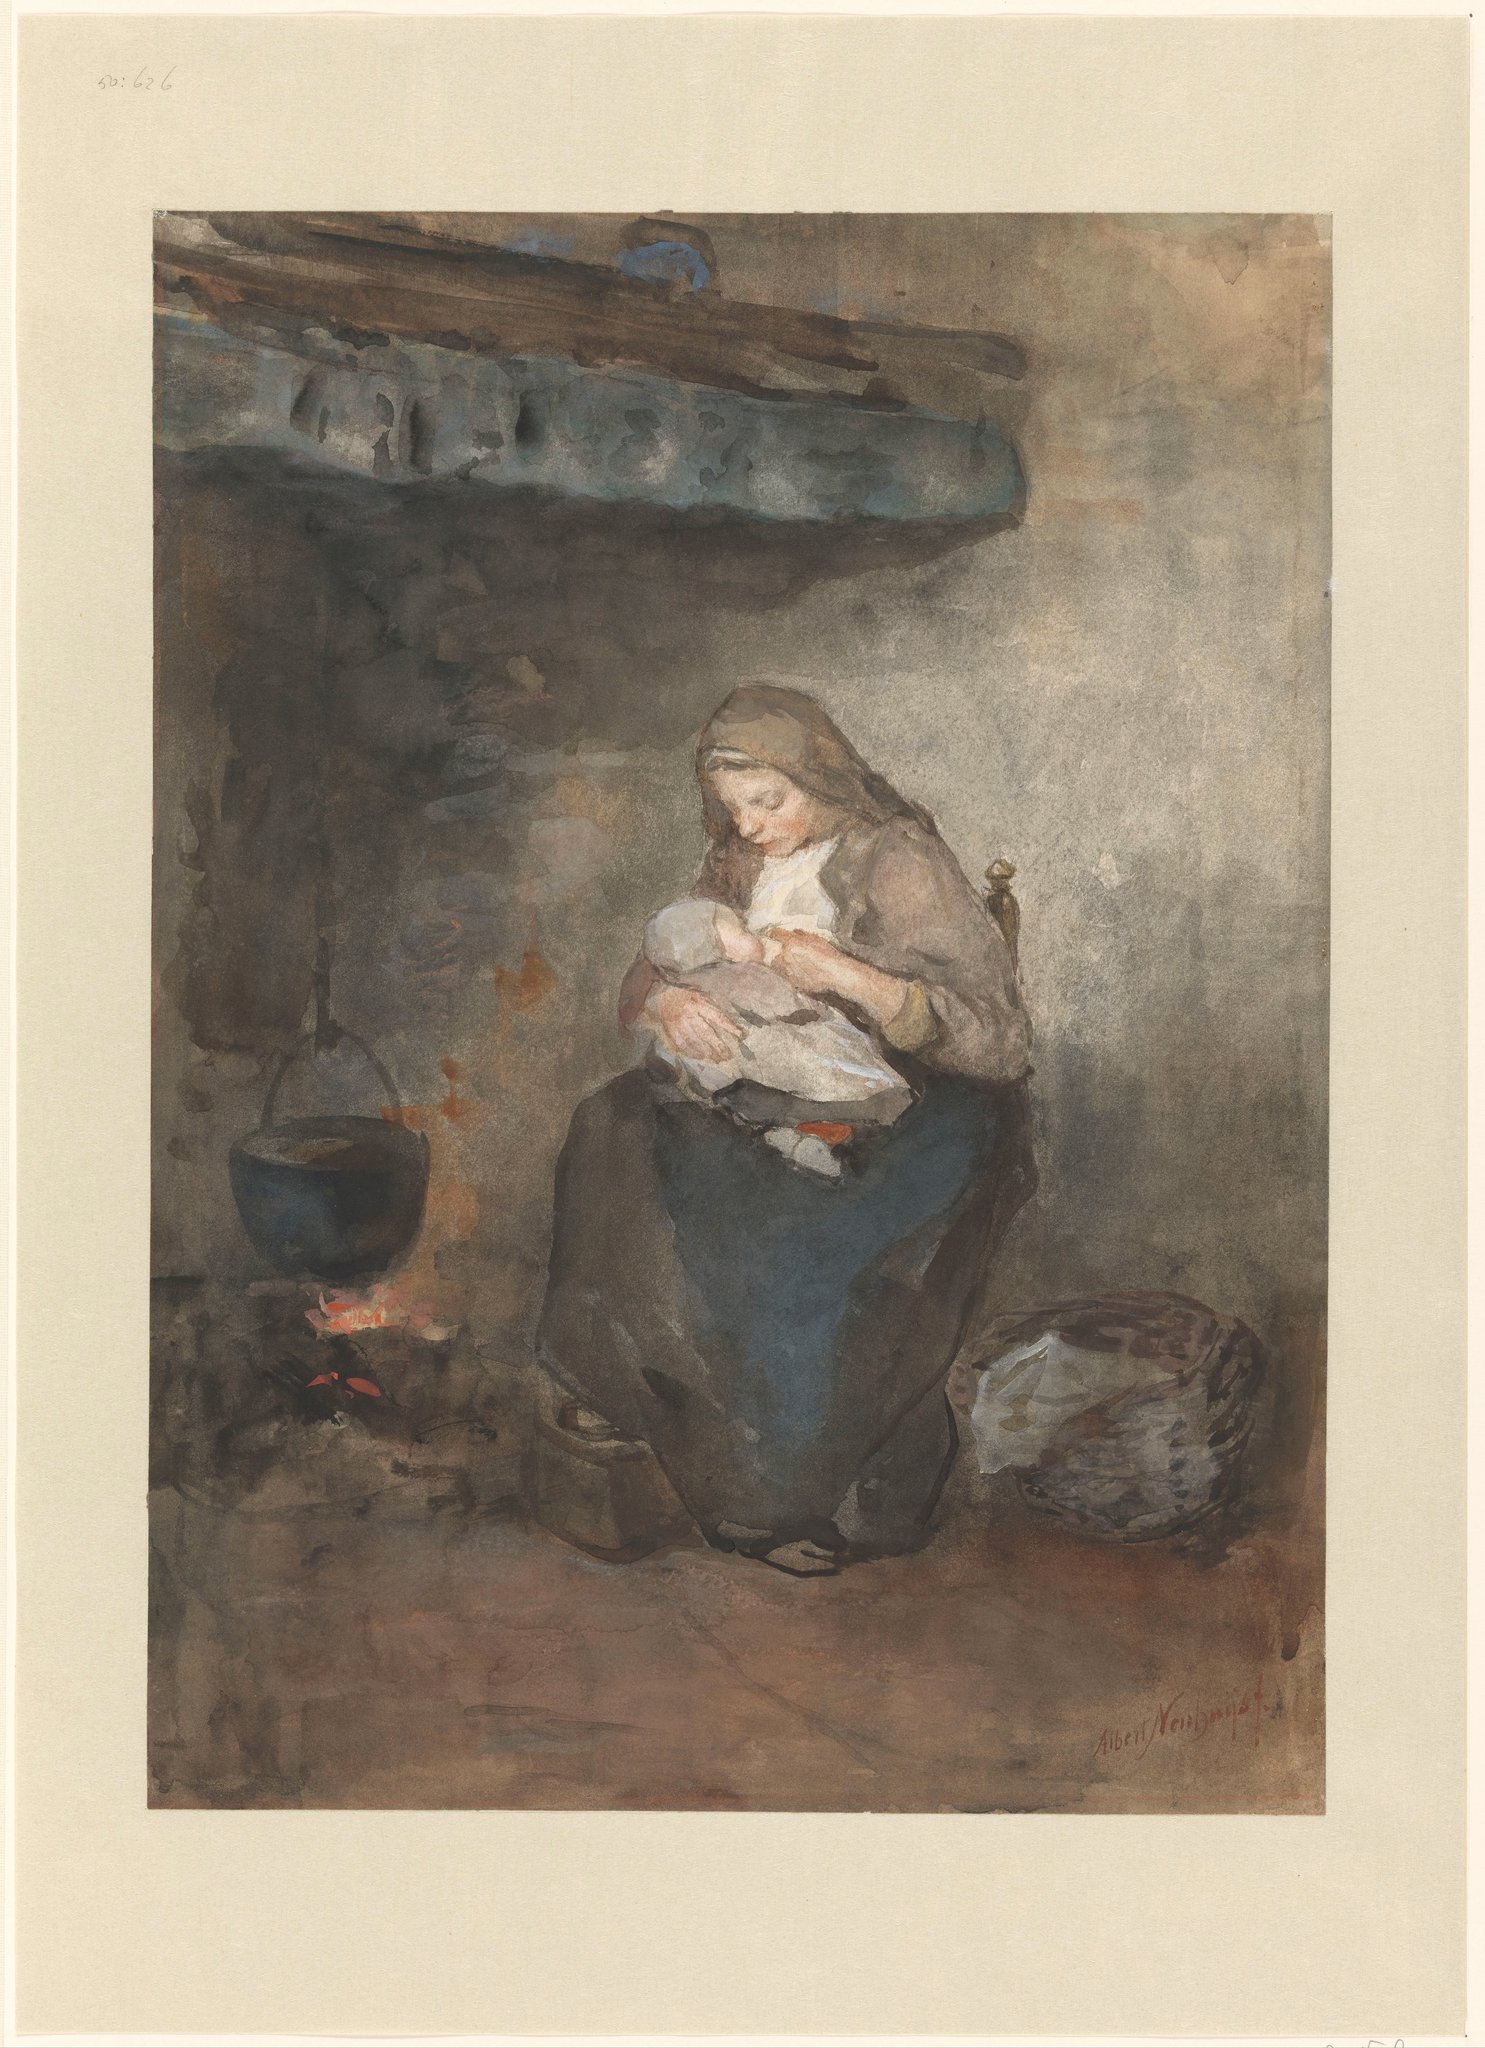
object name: watercolor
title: Moeder zoogt haar kind bij de haard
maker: albert neuhuys (1844-1914)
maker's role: draughtsman, painter, print maker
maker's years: 1844-1914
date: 1854-1914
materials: paper, watercolor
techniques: brush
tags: nursing, suckling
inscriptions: signature: ‘Albert Neuhuys f.’